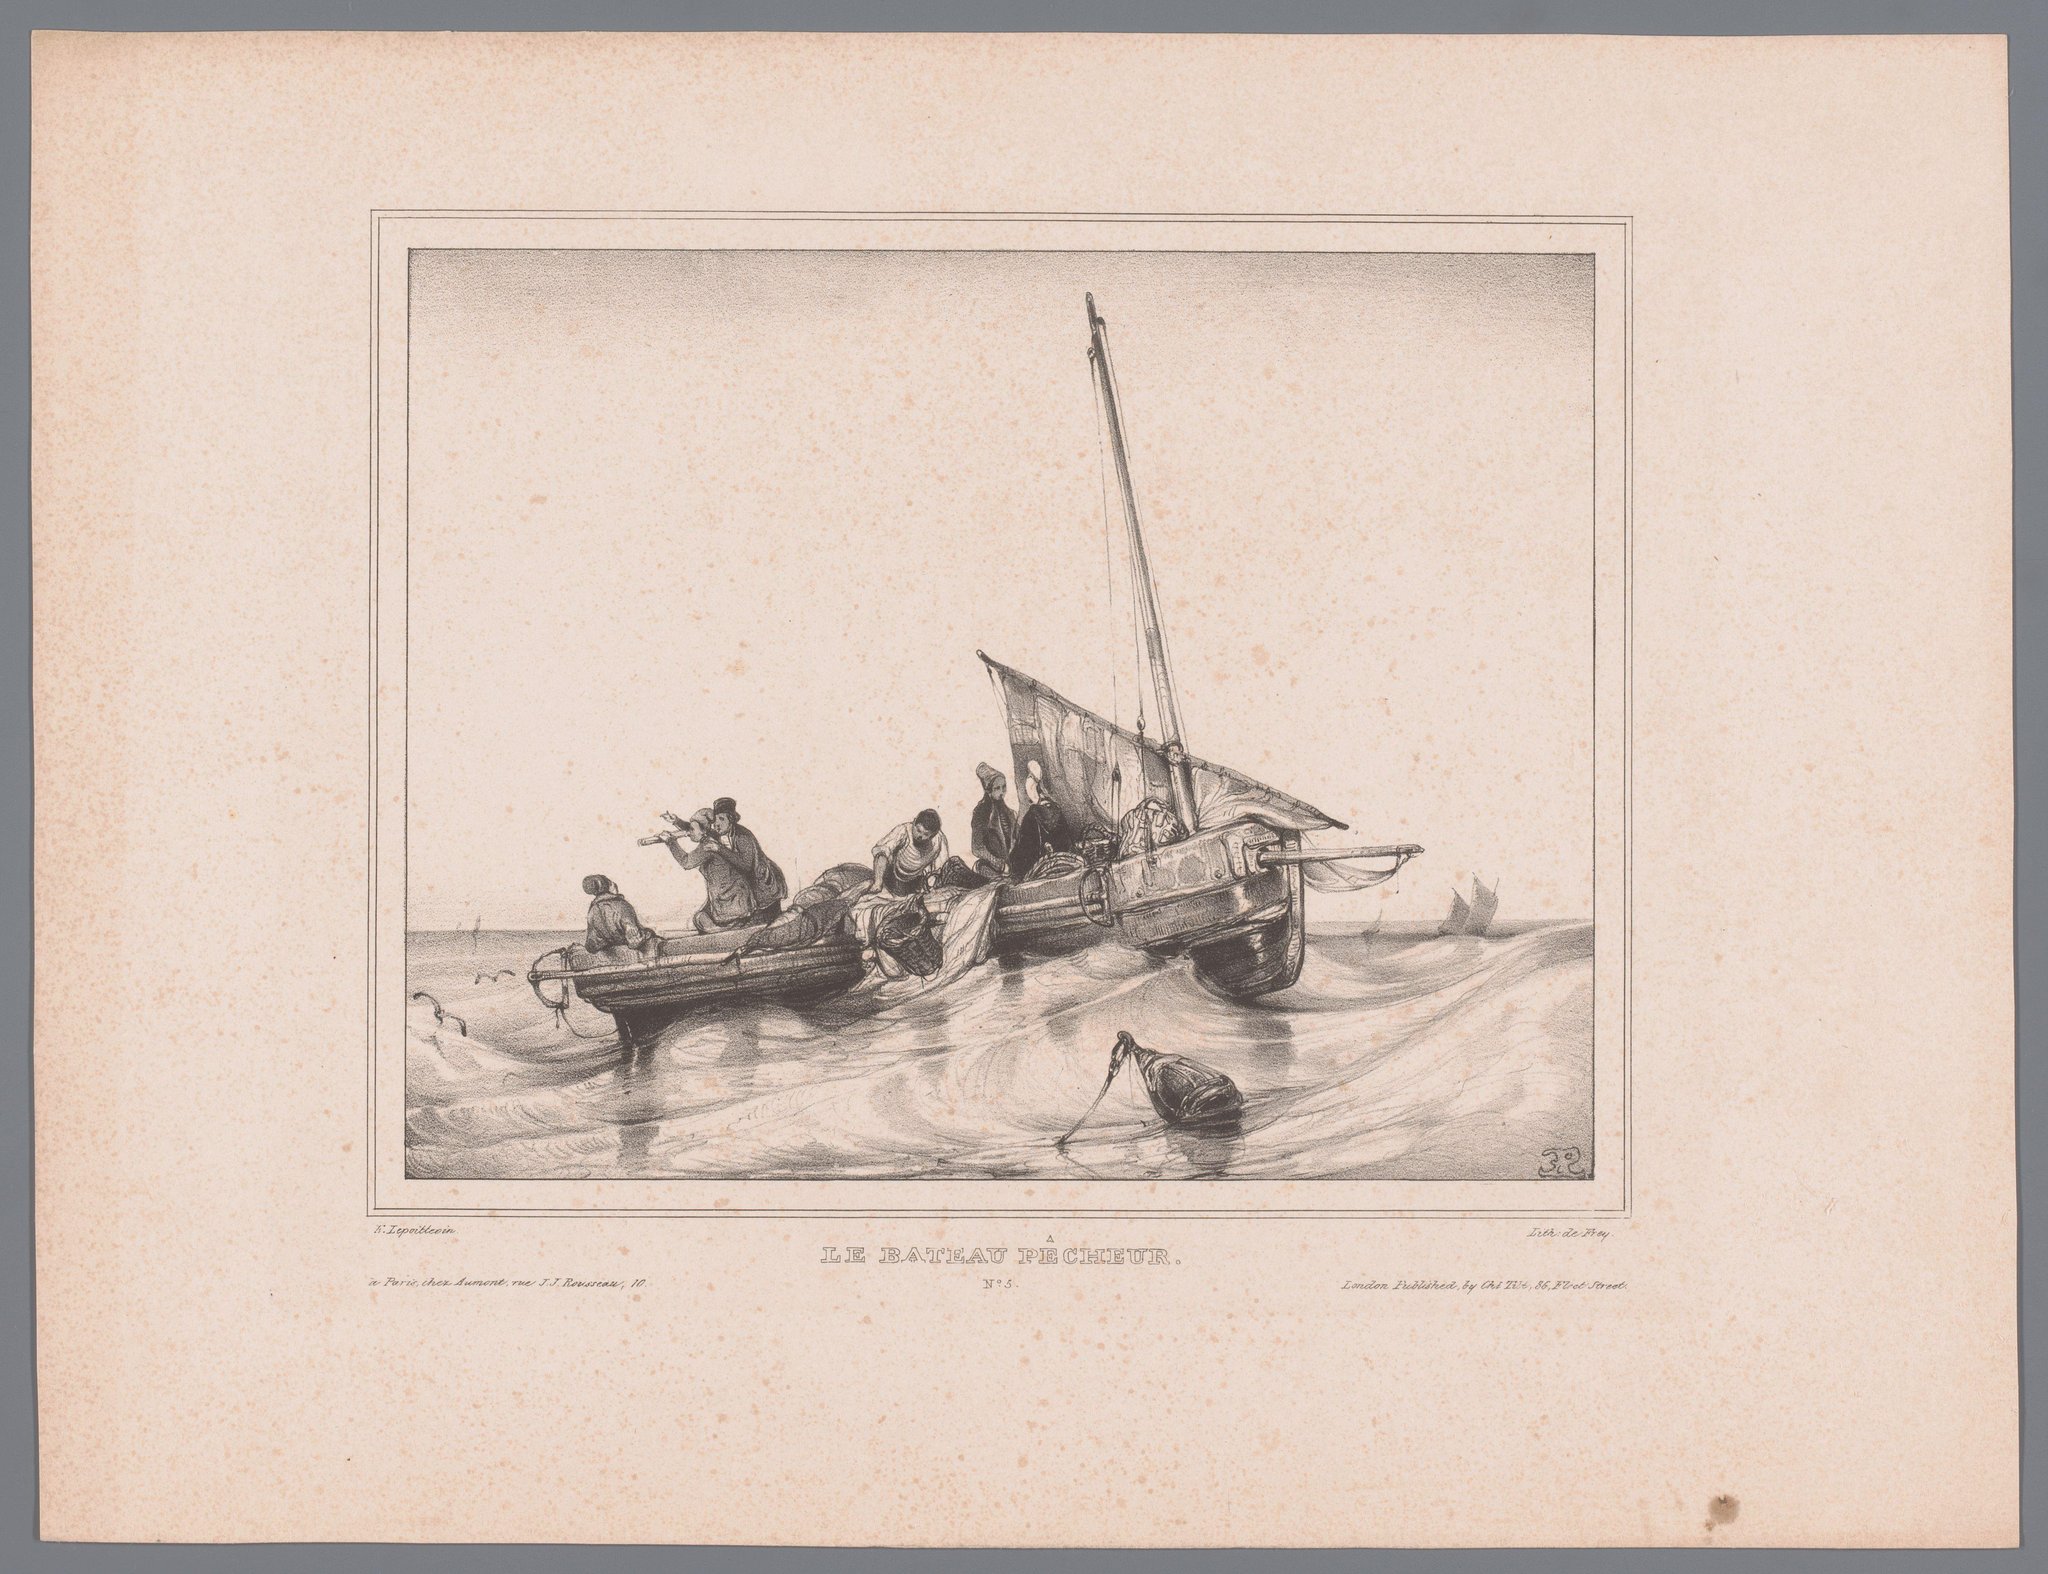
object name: print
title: Le bateau pêcheur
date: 1832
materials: paper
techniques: lithograph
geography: paris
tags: sailing-ship, sailing-boat, sea and coastal fishery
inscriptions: collector's mark: Lugt 2228a